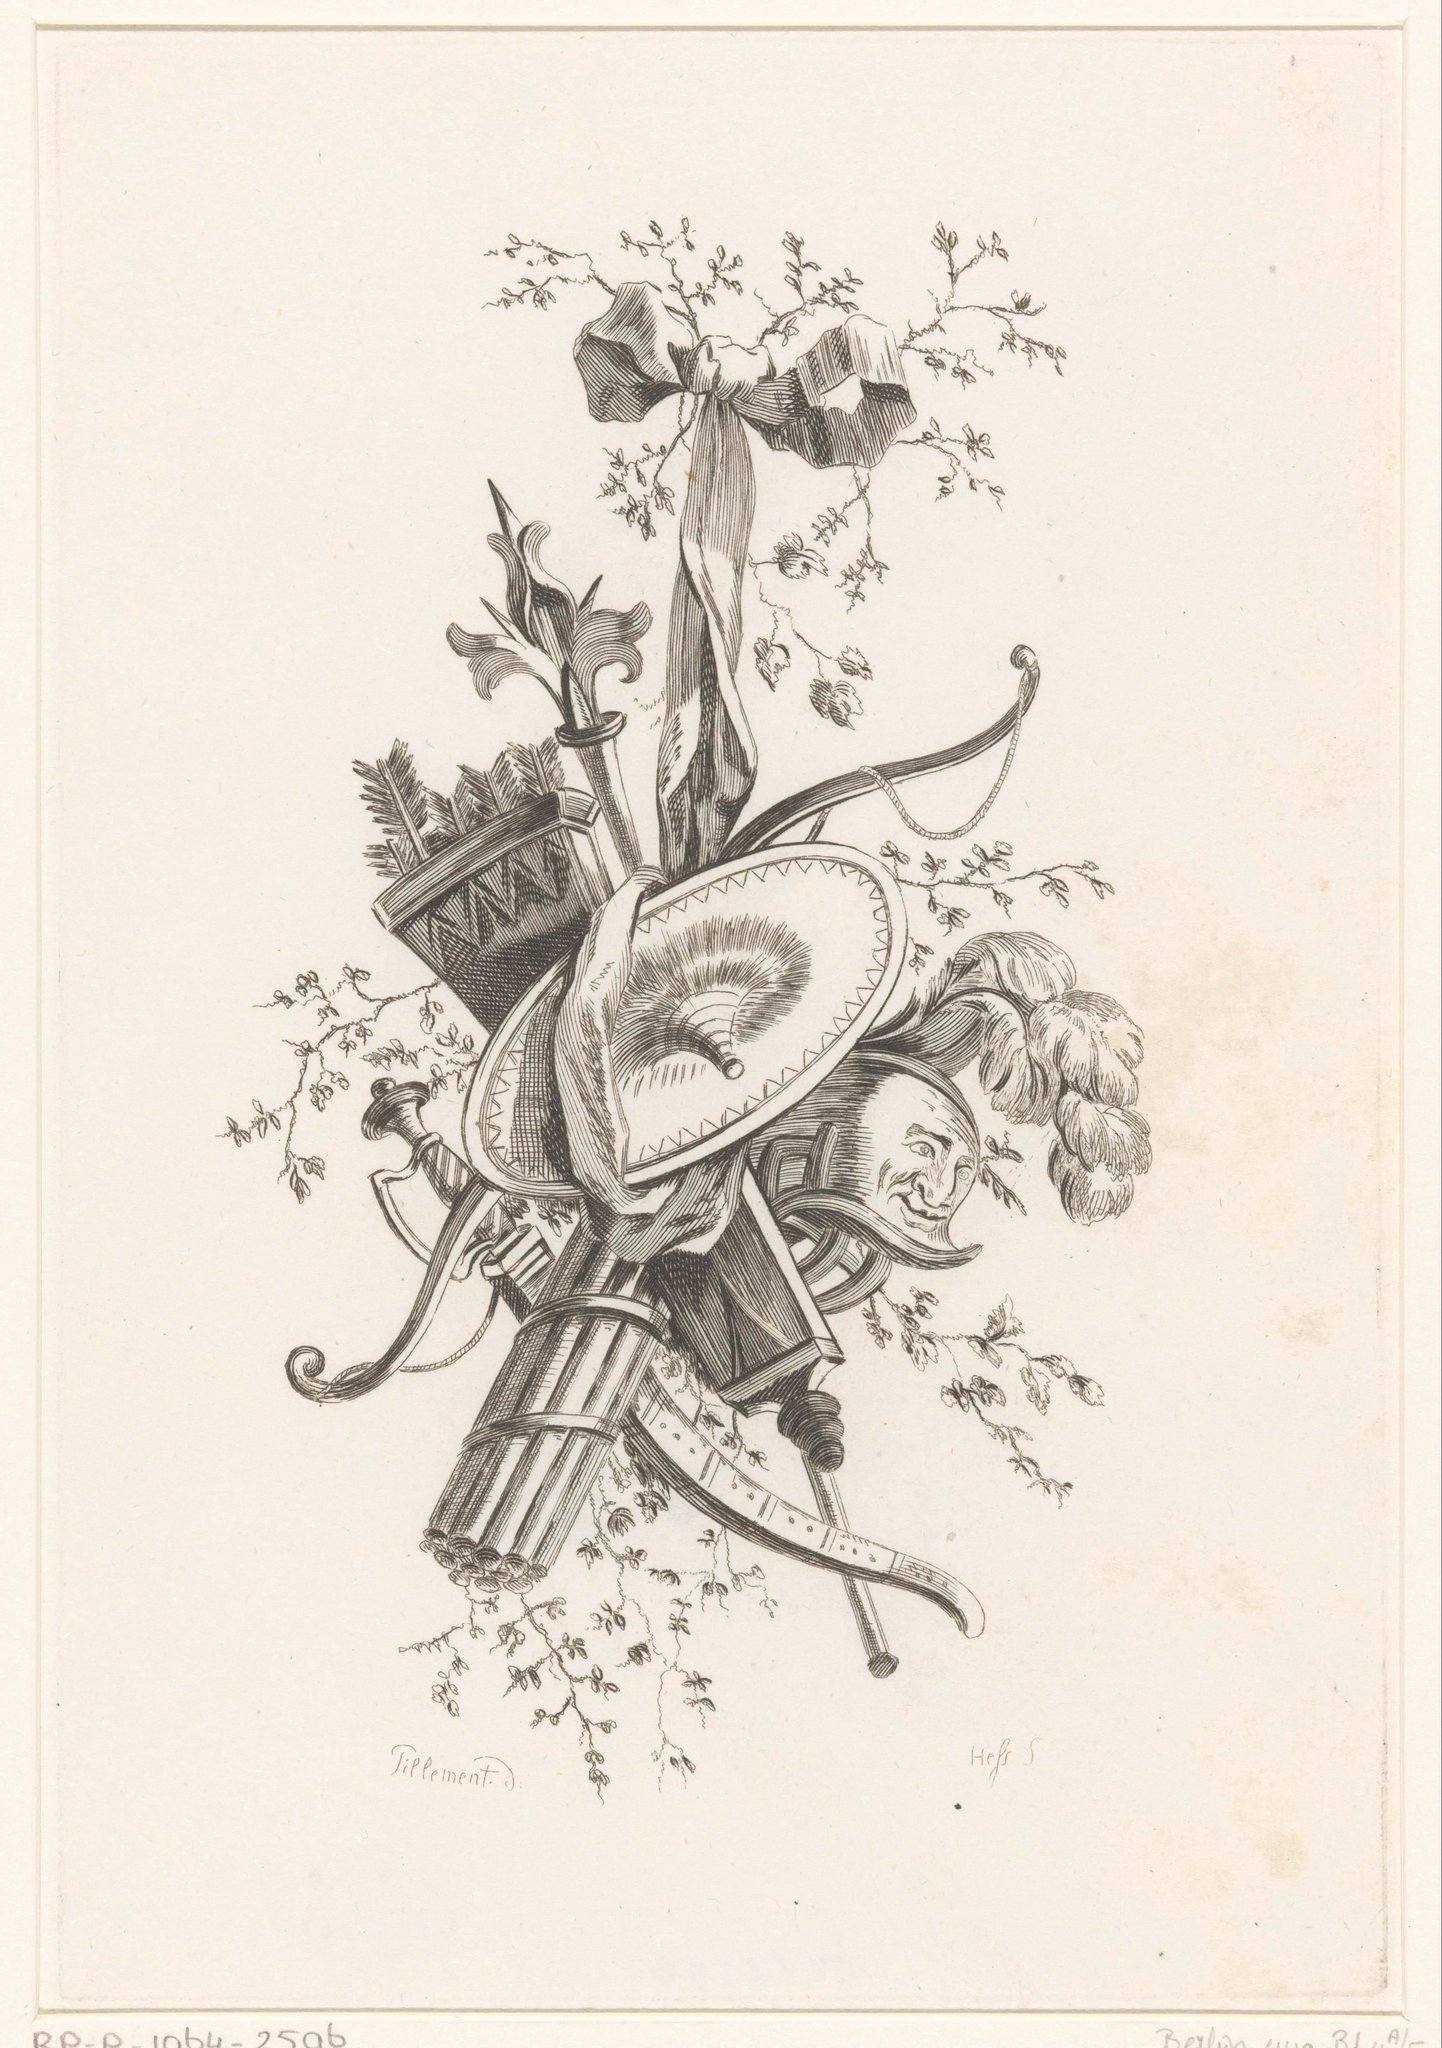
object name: print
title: Recueil Des Trophés Chinoises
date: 1770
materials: paper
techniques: etching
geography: paris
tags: protective weapons: shield, trophy, i.e.: decorative arrangement of symbolic or typical objects ~ ornament, weapons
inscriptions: collector's mark: Lugt 2760, collector's mark: Lugt 2228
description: Een trofee met een schild en wapens zoals een boog, een fasces, een steekwapen, een pijlenkoker en een pluimenhelm.